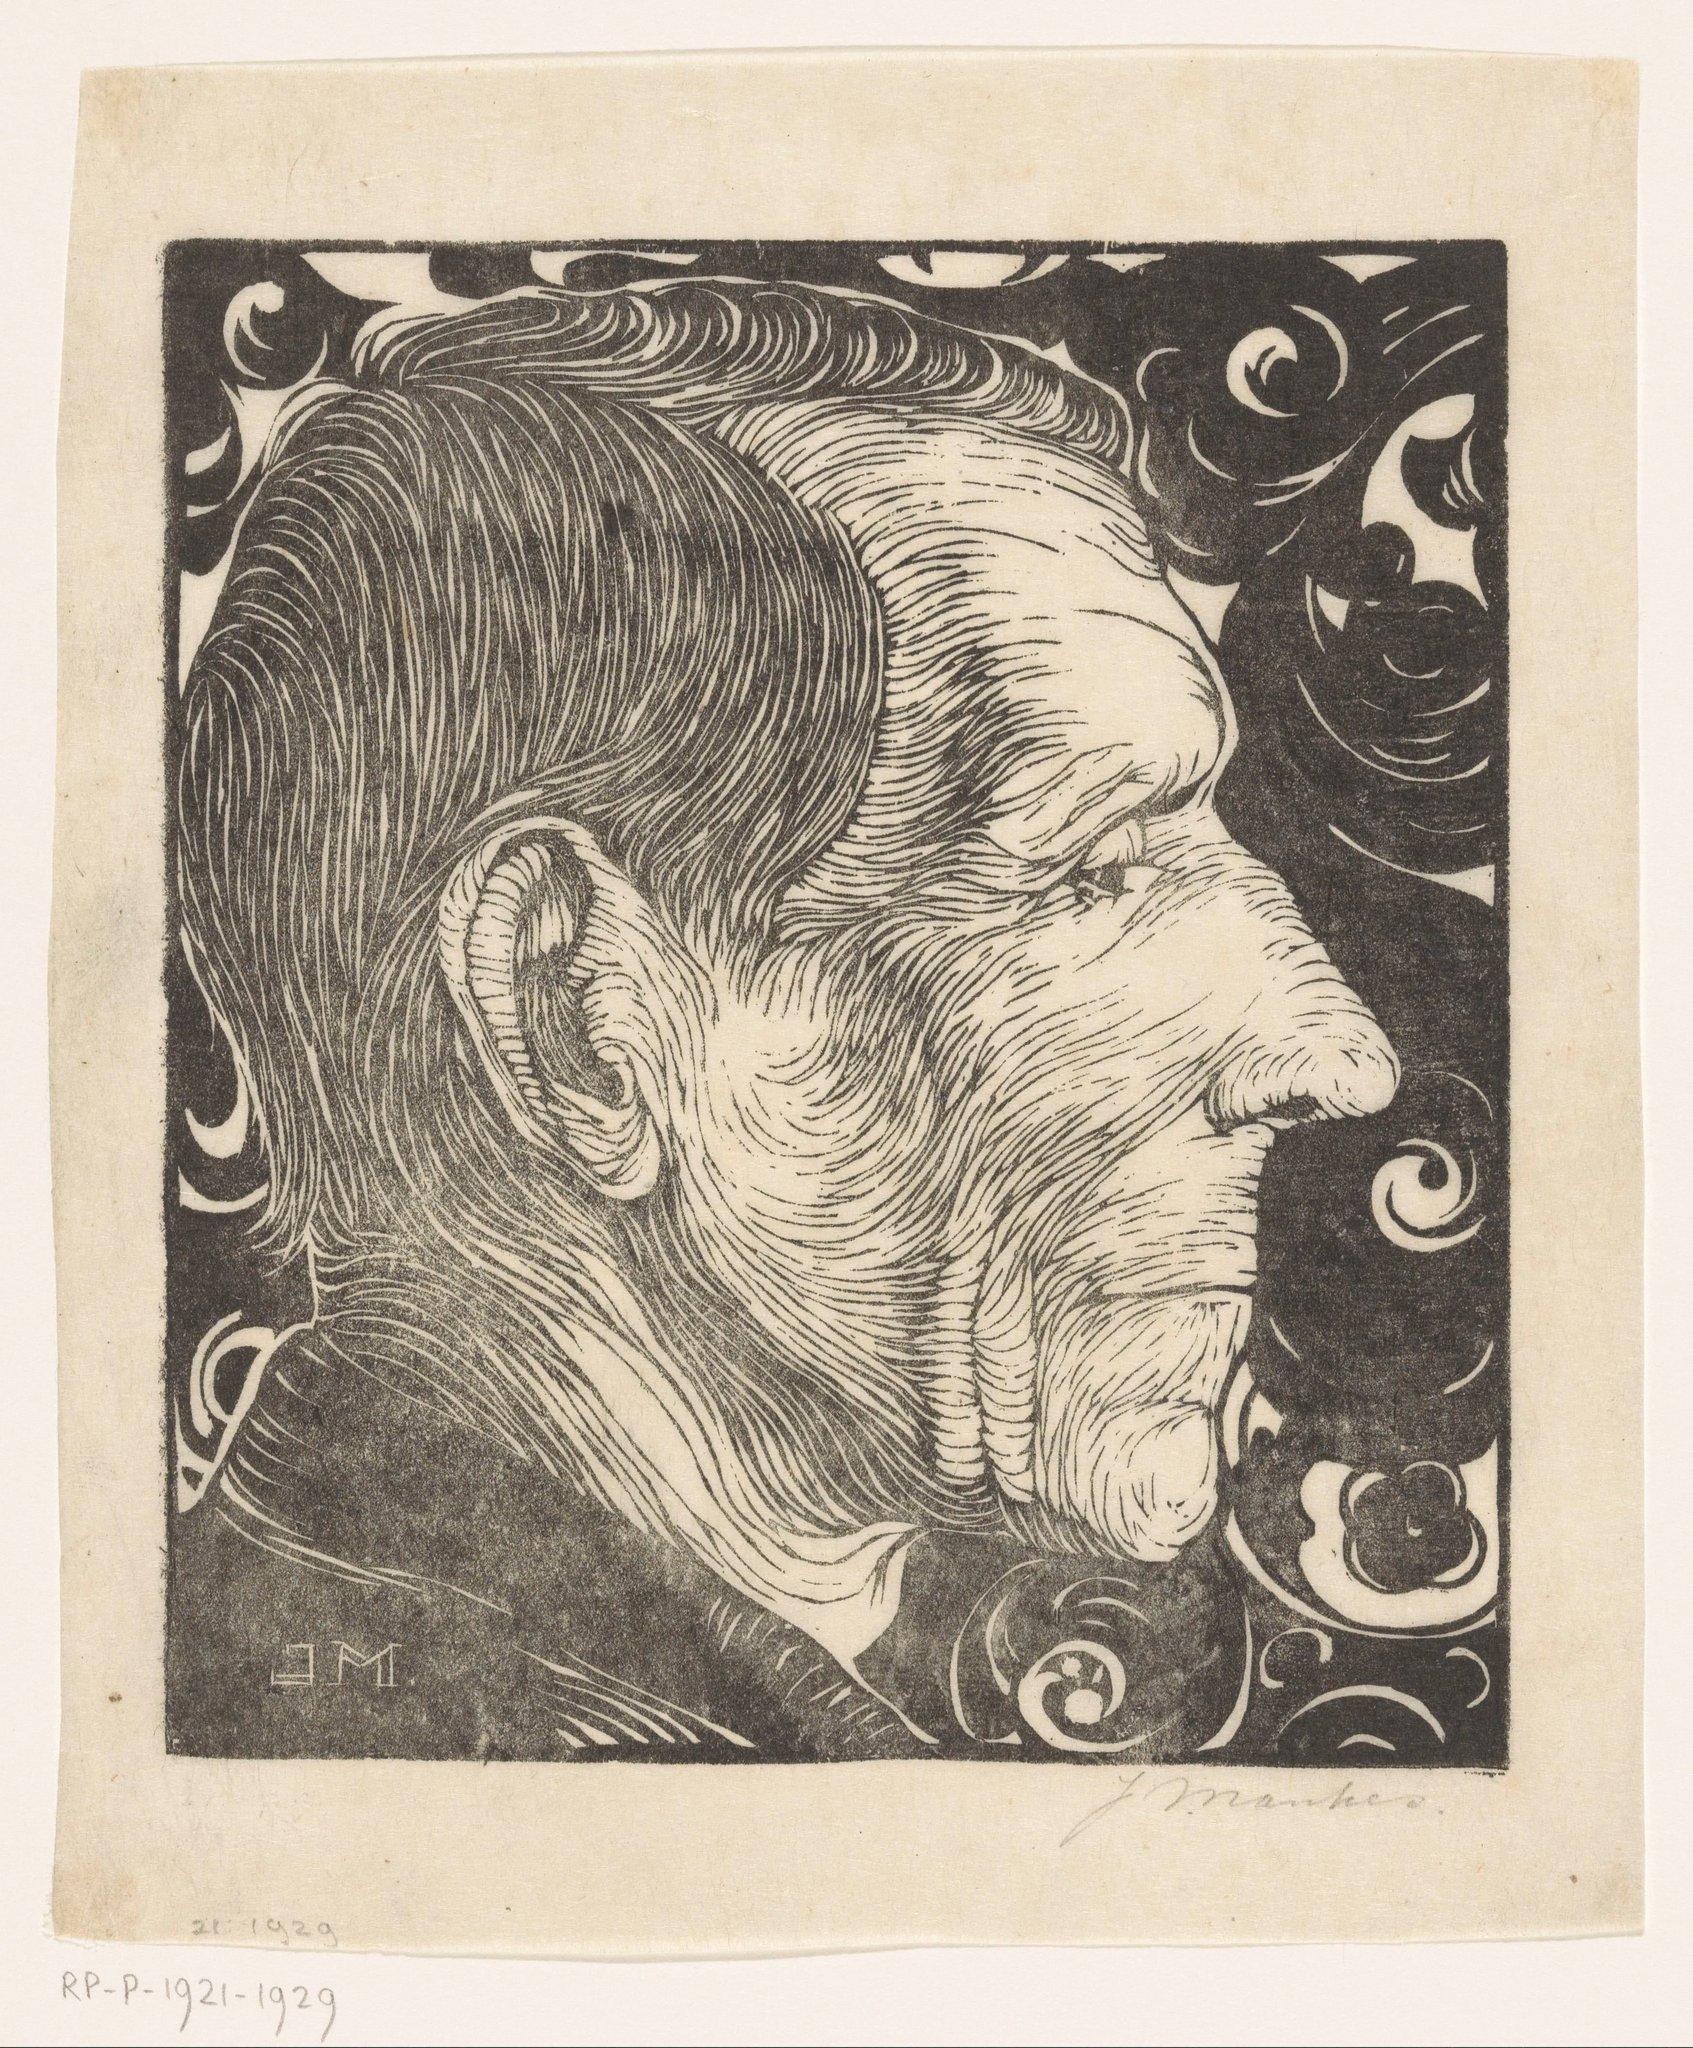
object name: print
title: Portret van Beint Mankes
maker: jan mankes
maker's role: draughtsman, painter, print maker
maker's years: 1889-1920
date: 1914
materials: paper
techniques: woodcut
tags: beint mankes (i)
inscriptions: collector's mark: Lugt 2228